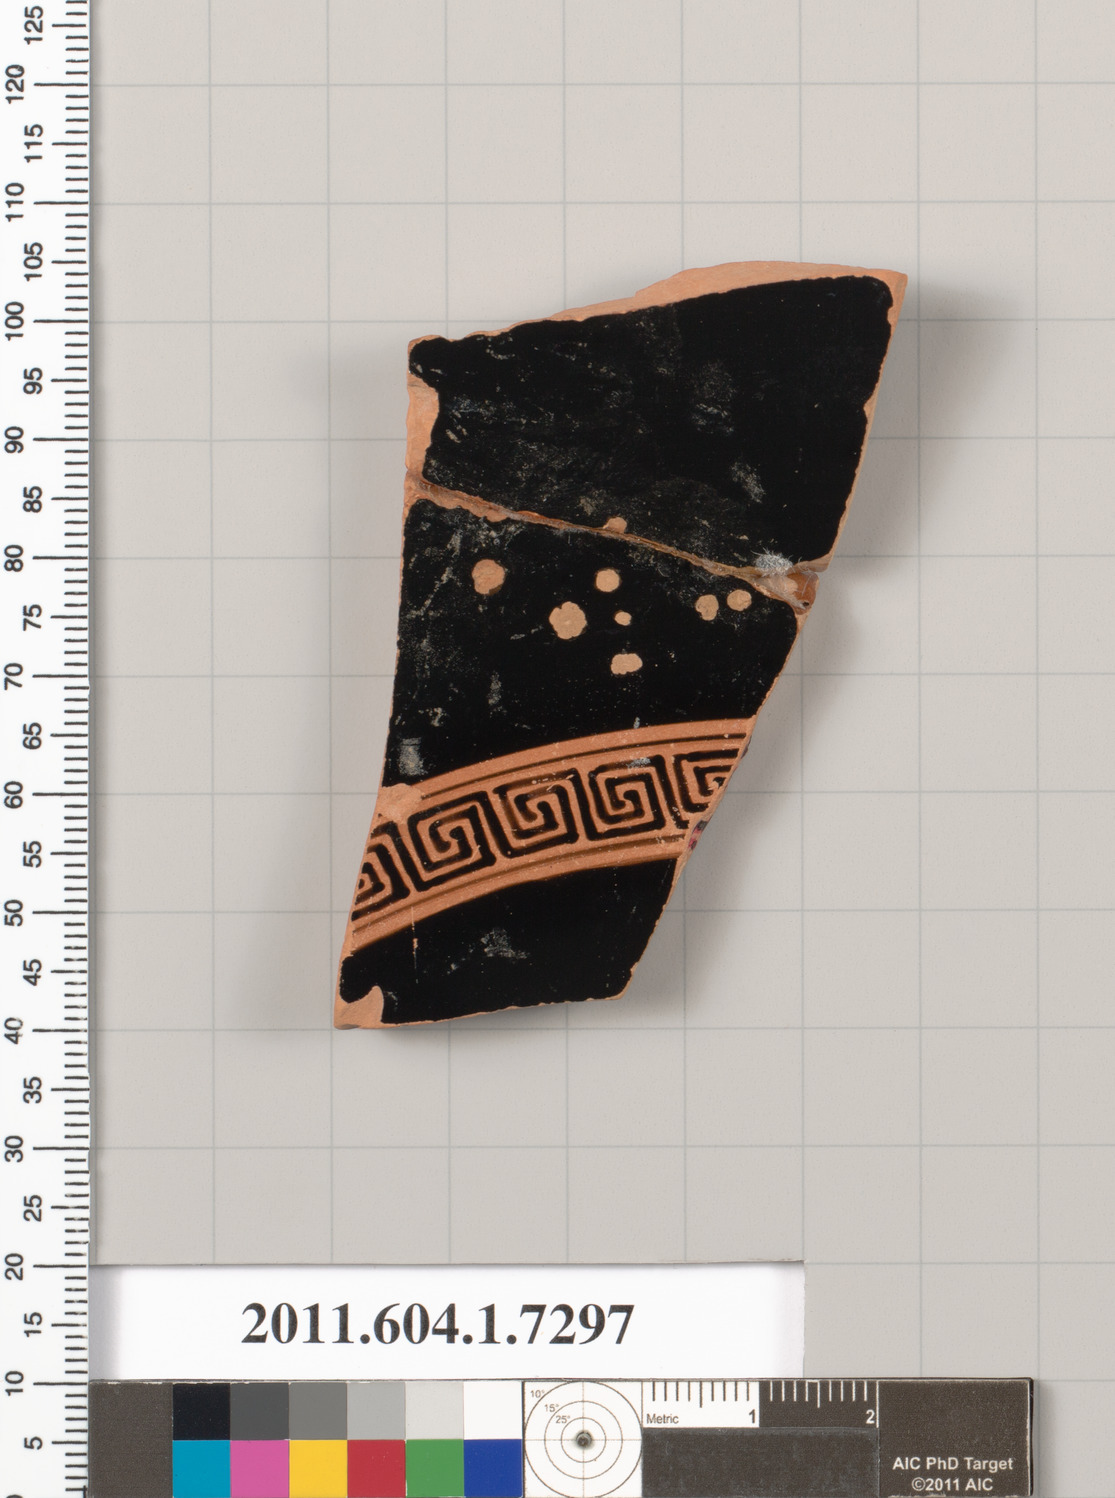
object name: kylix fragment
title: Terracotta fragment of a kylix (drinking cup)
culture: greek, attic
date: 500-480 BCE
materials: terracotta